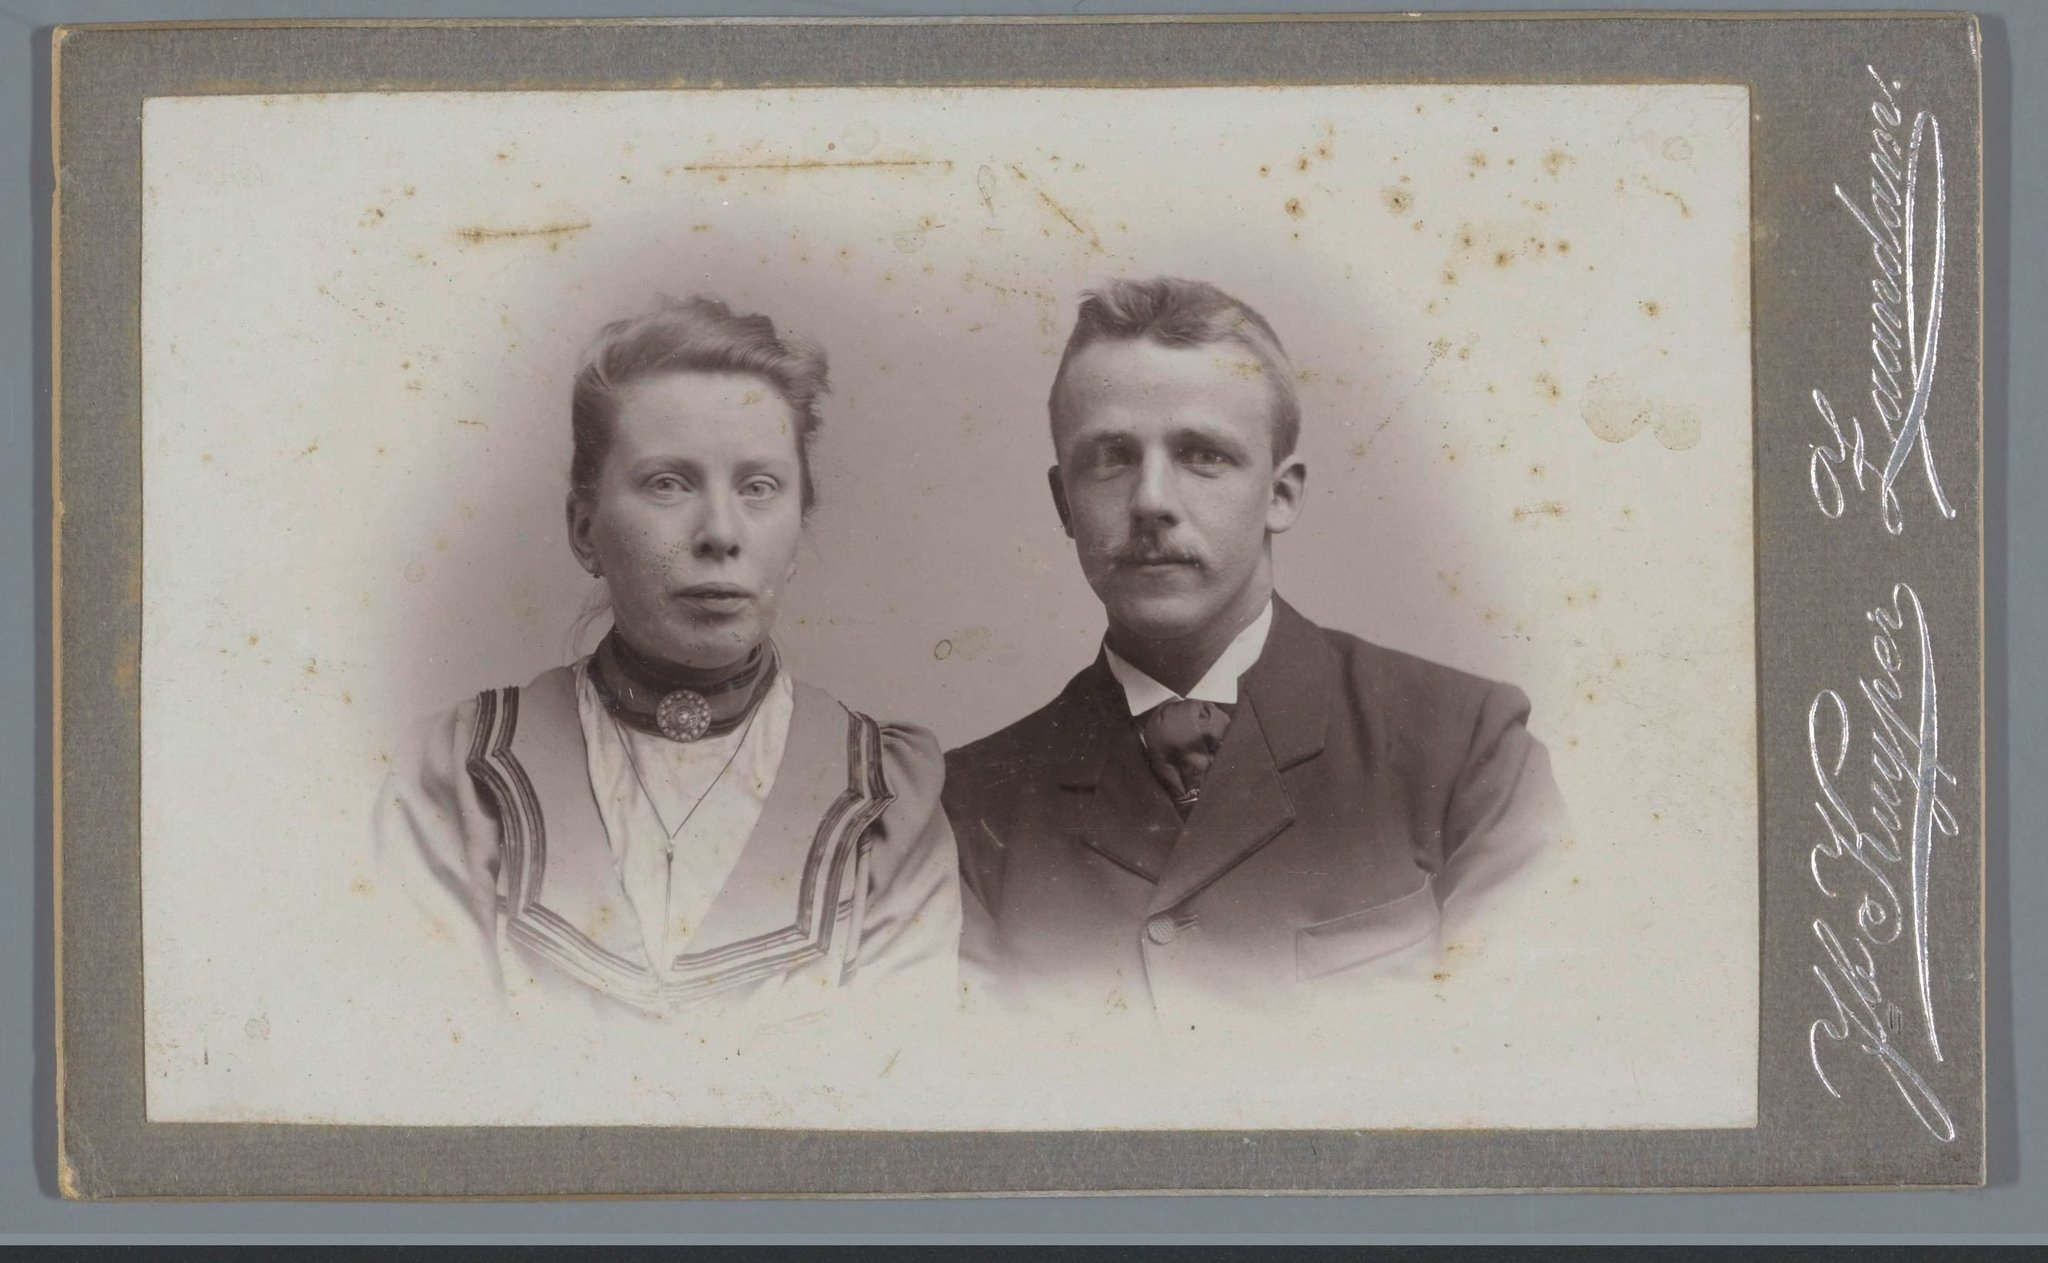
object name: photograph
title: Portret van een onbekende man en een onbekende vrouw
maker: jacob kuyper (1851-1919)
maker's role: fotograaf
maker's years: 1851-1919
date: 1880-1919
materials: cardboard, photographic support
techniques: collodion silver print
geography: zaandam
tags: adult woman, adult man, historical persons